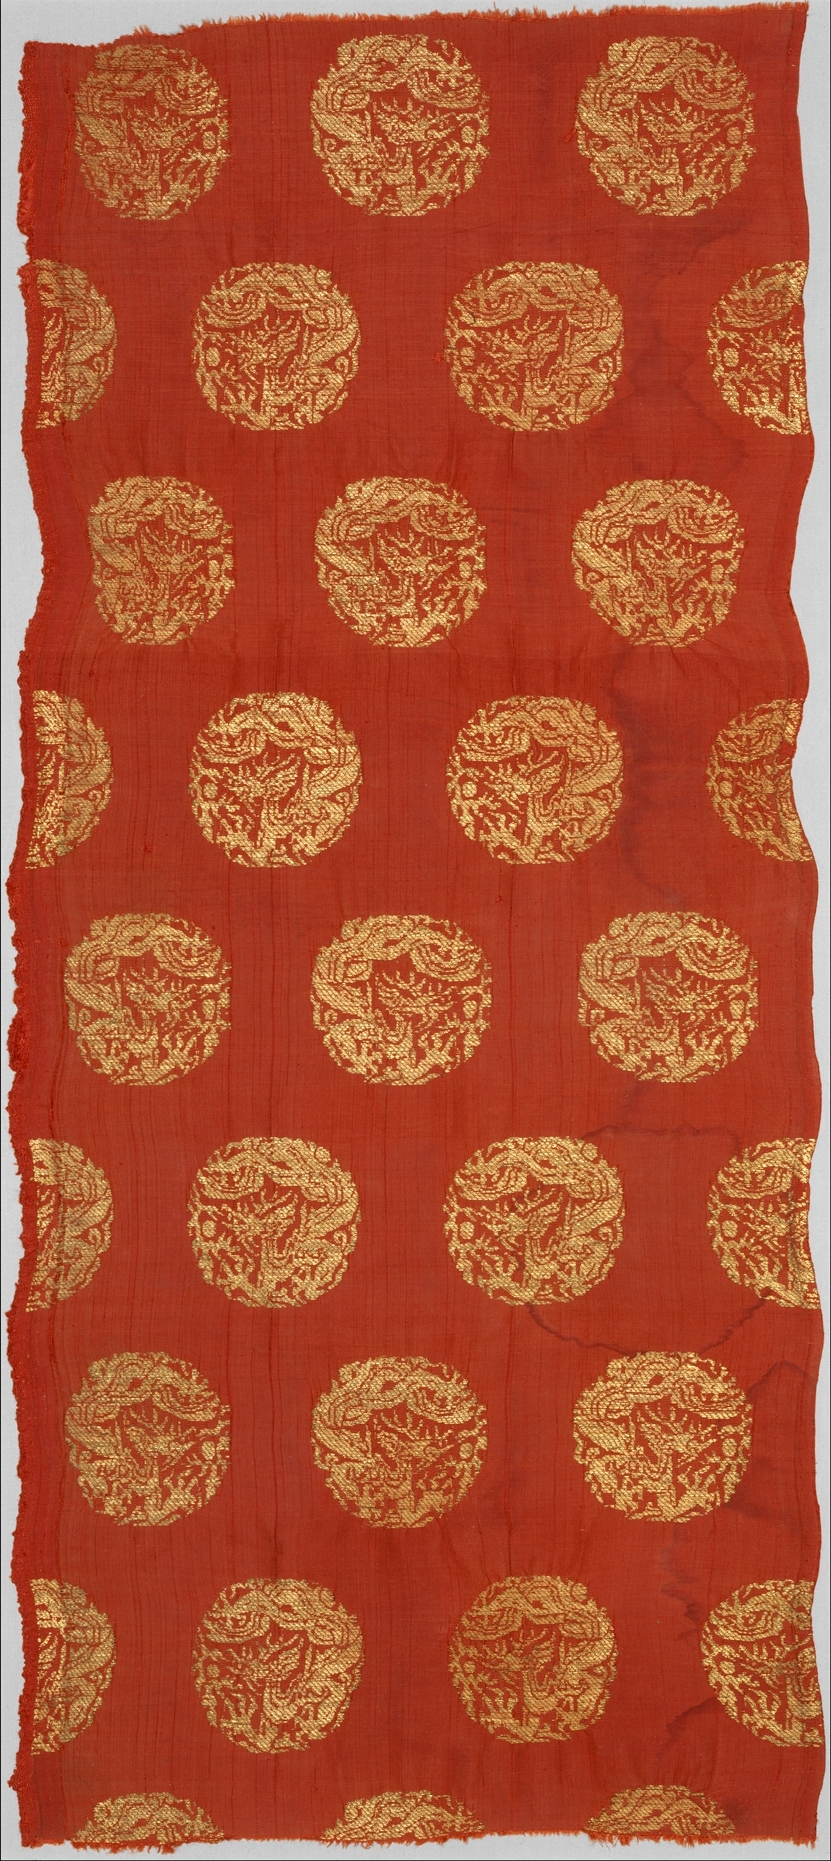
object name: textile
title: Textile with Coiled Dragons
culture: chinese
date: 1115-1234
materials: metal thread, silk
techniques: brocade, weave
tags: dragons